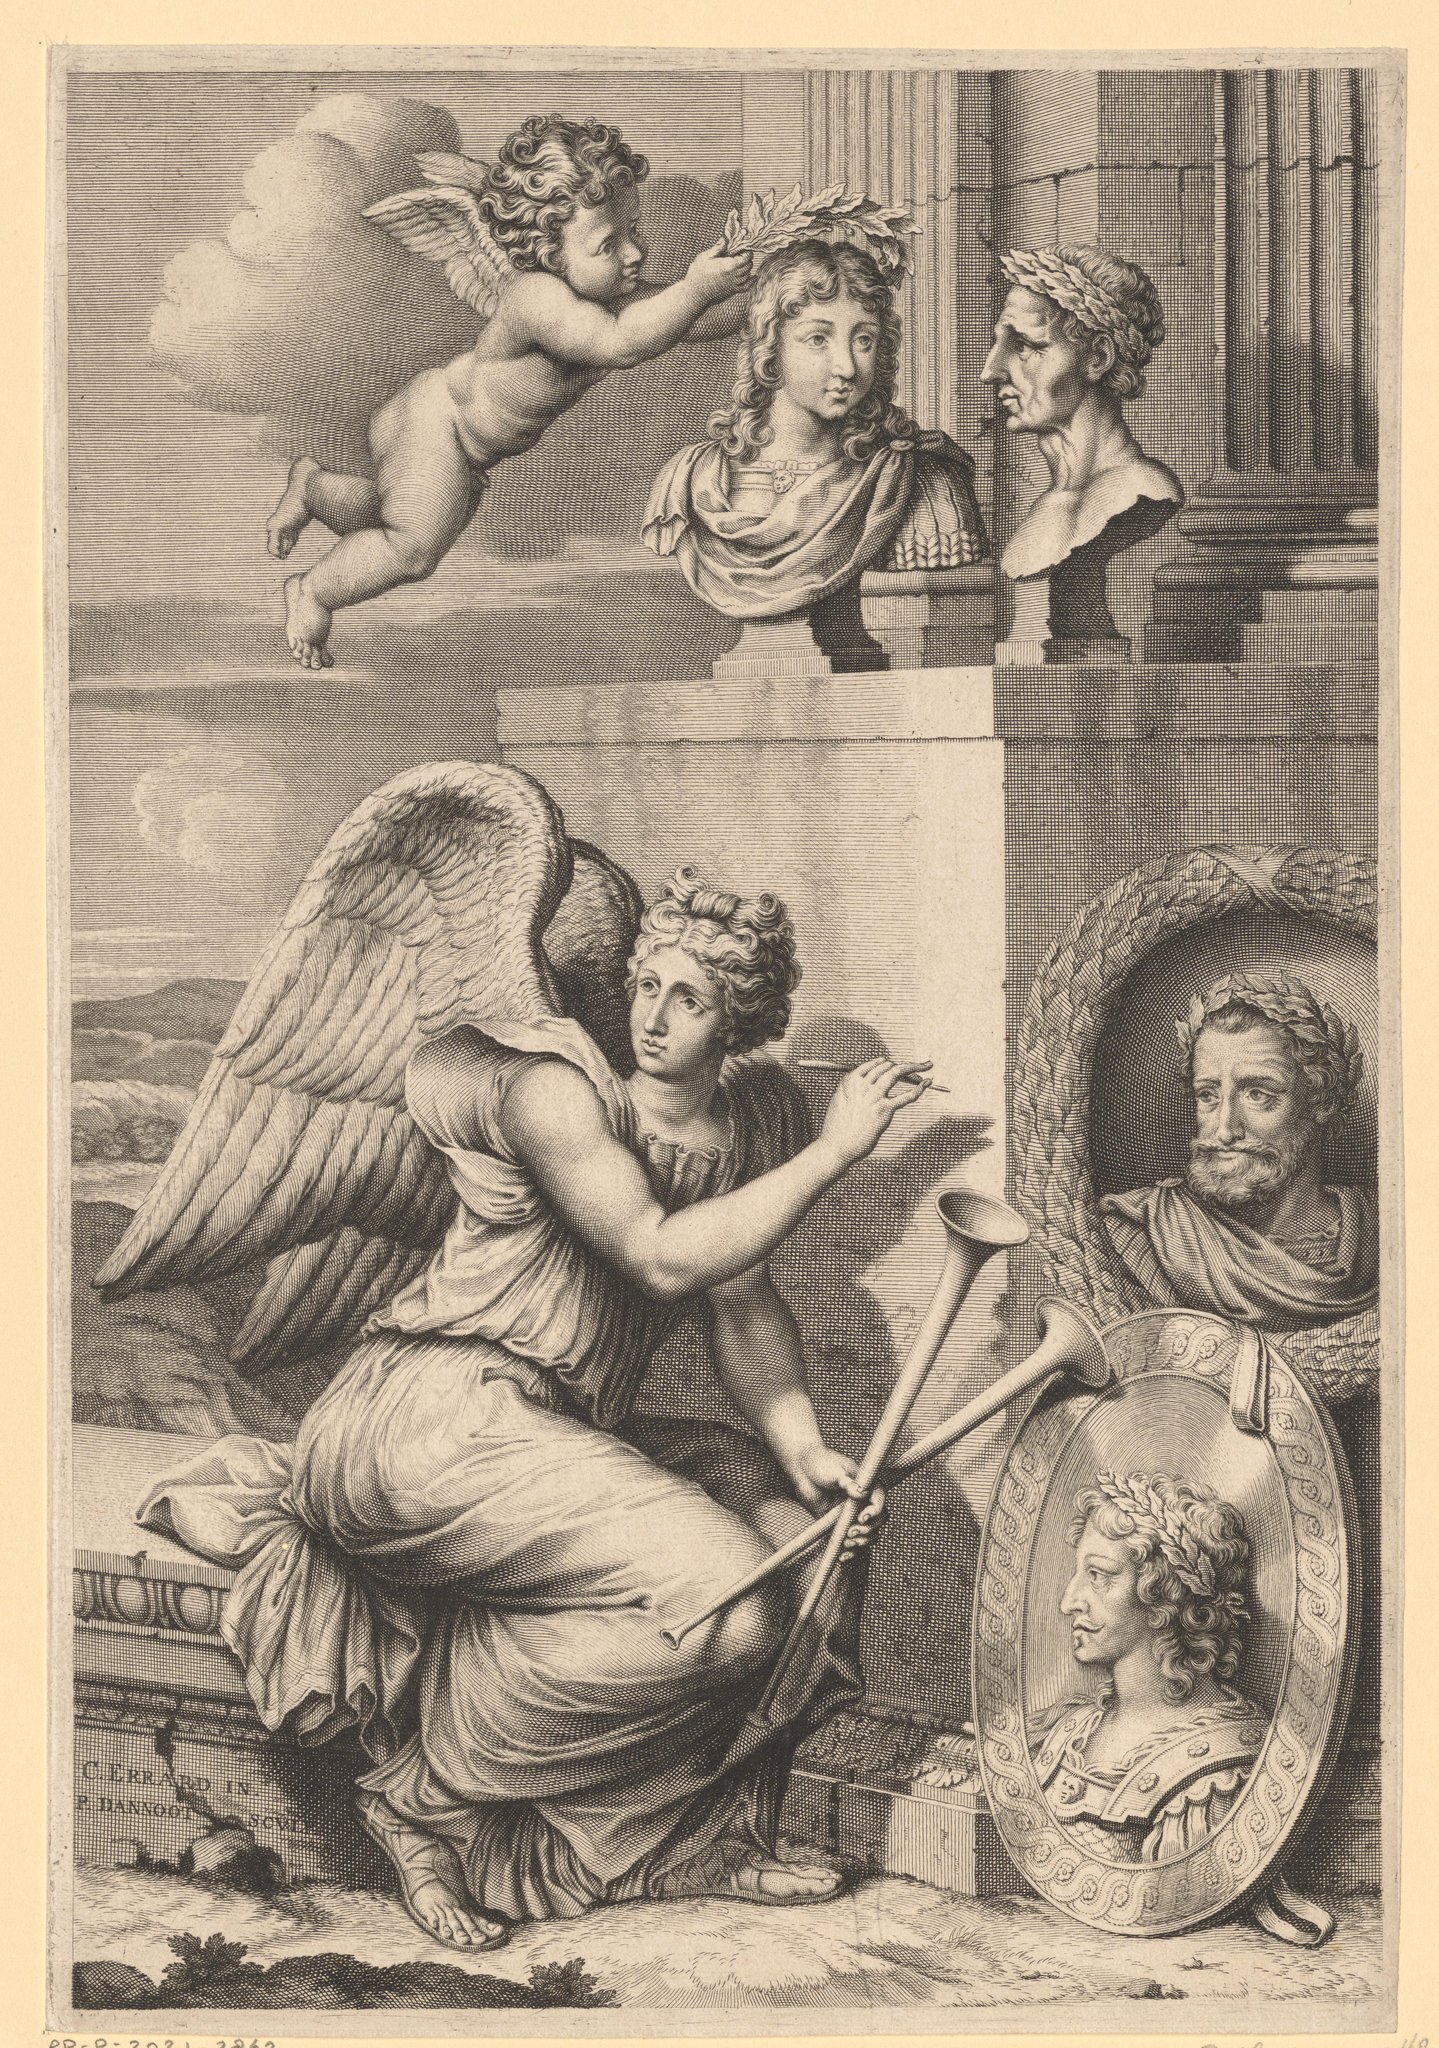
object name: print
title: Faam bij portretten en bustes van Franse koningen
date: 1654-1692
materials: paper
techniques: engraving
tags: lodewijk xiv (koning van frankrijk), hendrik iv (koning van frankrijk en navarra), lodewijk xiii (koning van frankrijk), historical persons, fame; 'fama', 'fama buona', 'fama chiara' (ripa), king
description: Met waarschijnlijk Lodewijk XIV, Lodewijk XIII en Hendrik IV, koningen van Frankrijk.